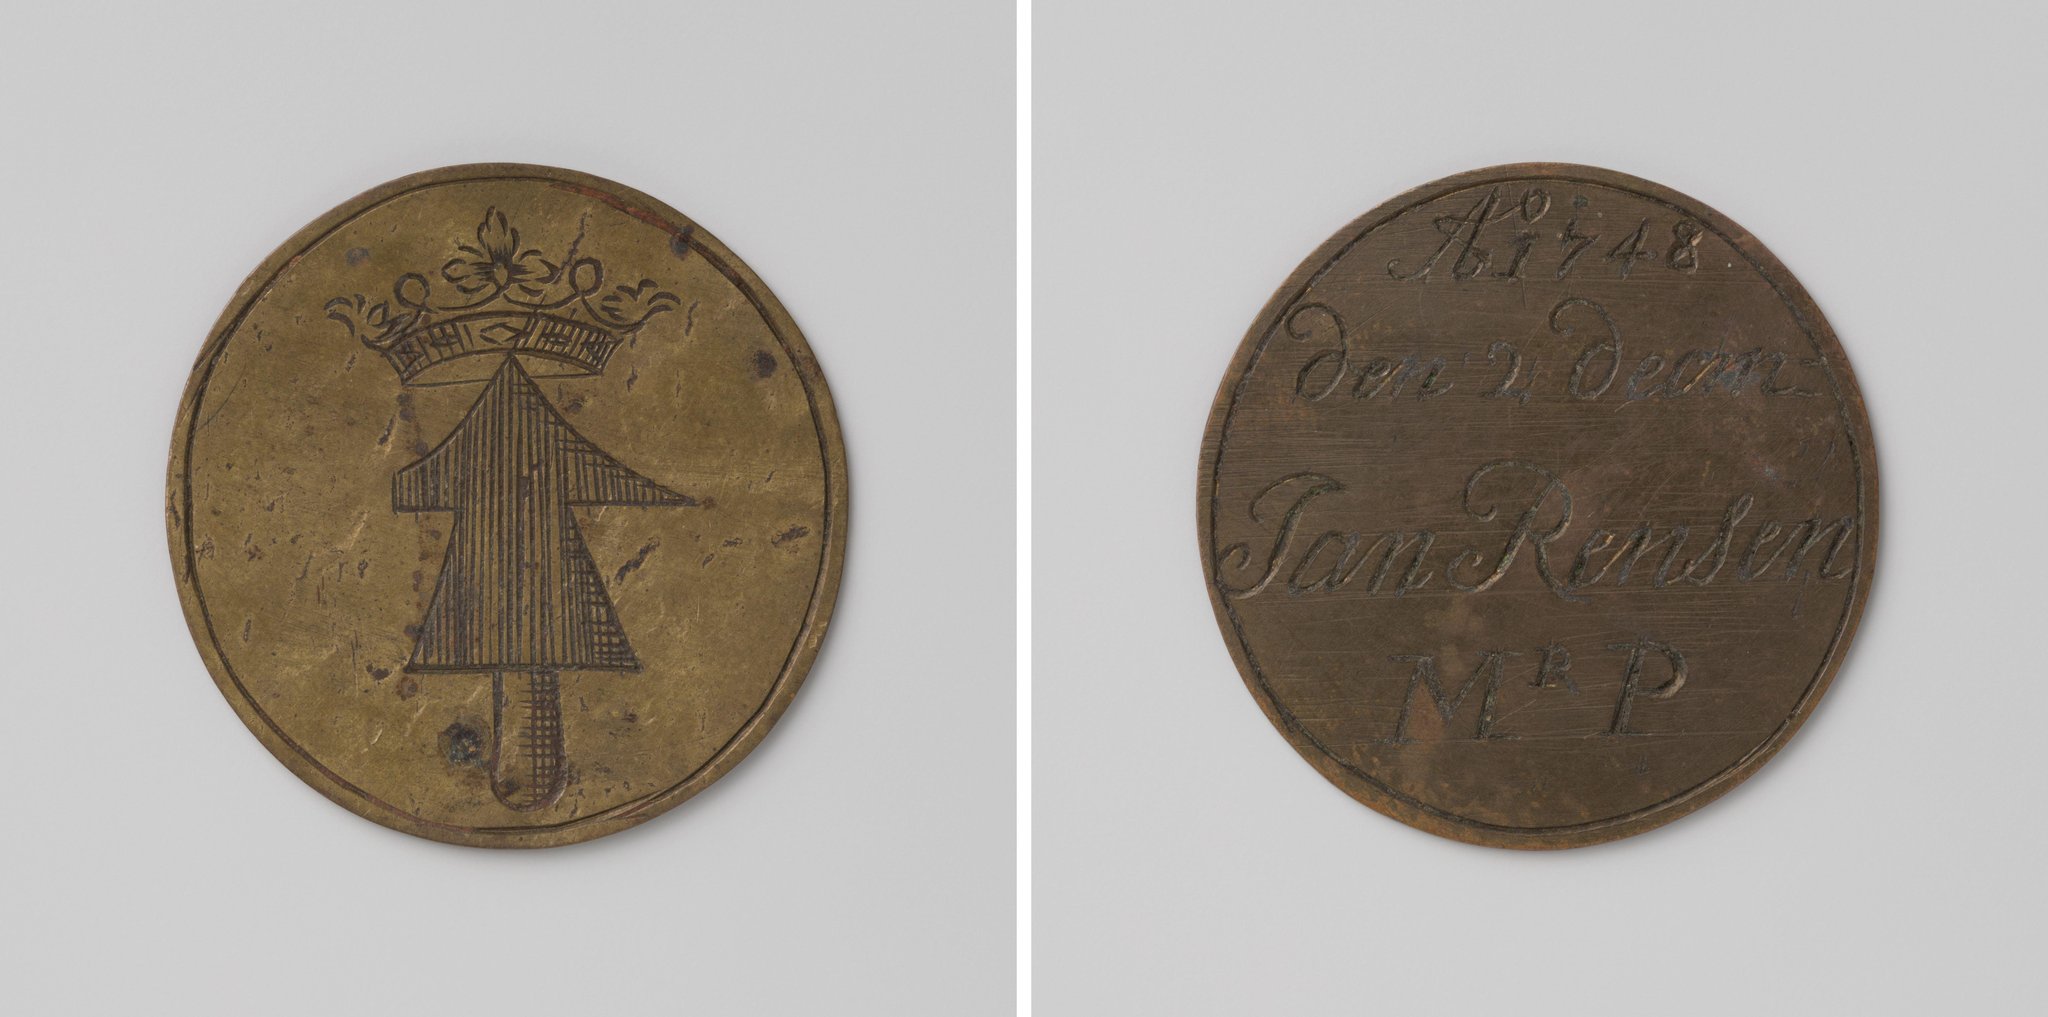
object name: medal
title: Metselaars-, steenhouwers-, leidekkers-, loodgieters- en pompenmakersgilde van Amsterdam, gildepenning van Jan Rensen, meester pompmaker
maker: Anonymous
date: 1748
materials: brass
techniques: engraving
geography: amsterdam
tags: amsterdam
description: Messing penning. Voorzijde: gekroonde loodgietershamer. Keerzijde: opschrift